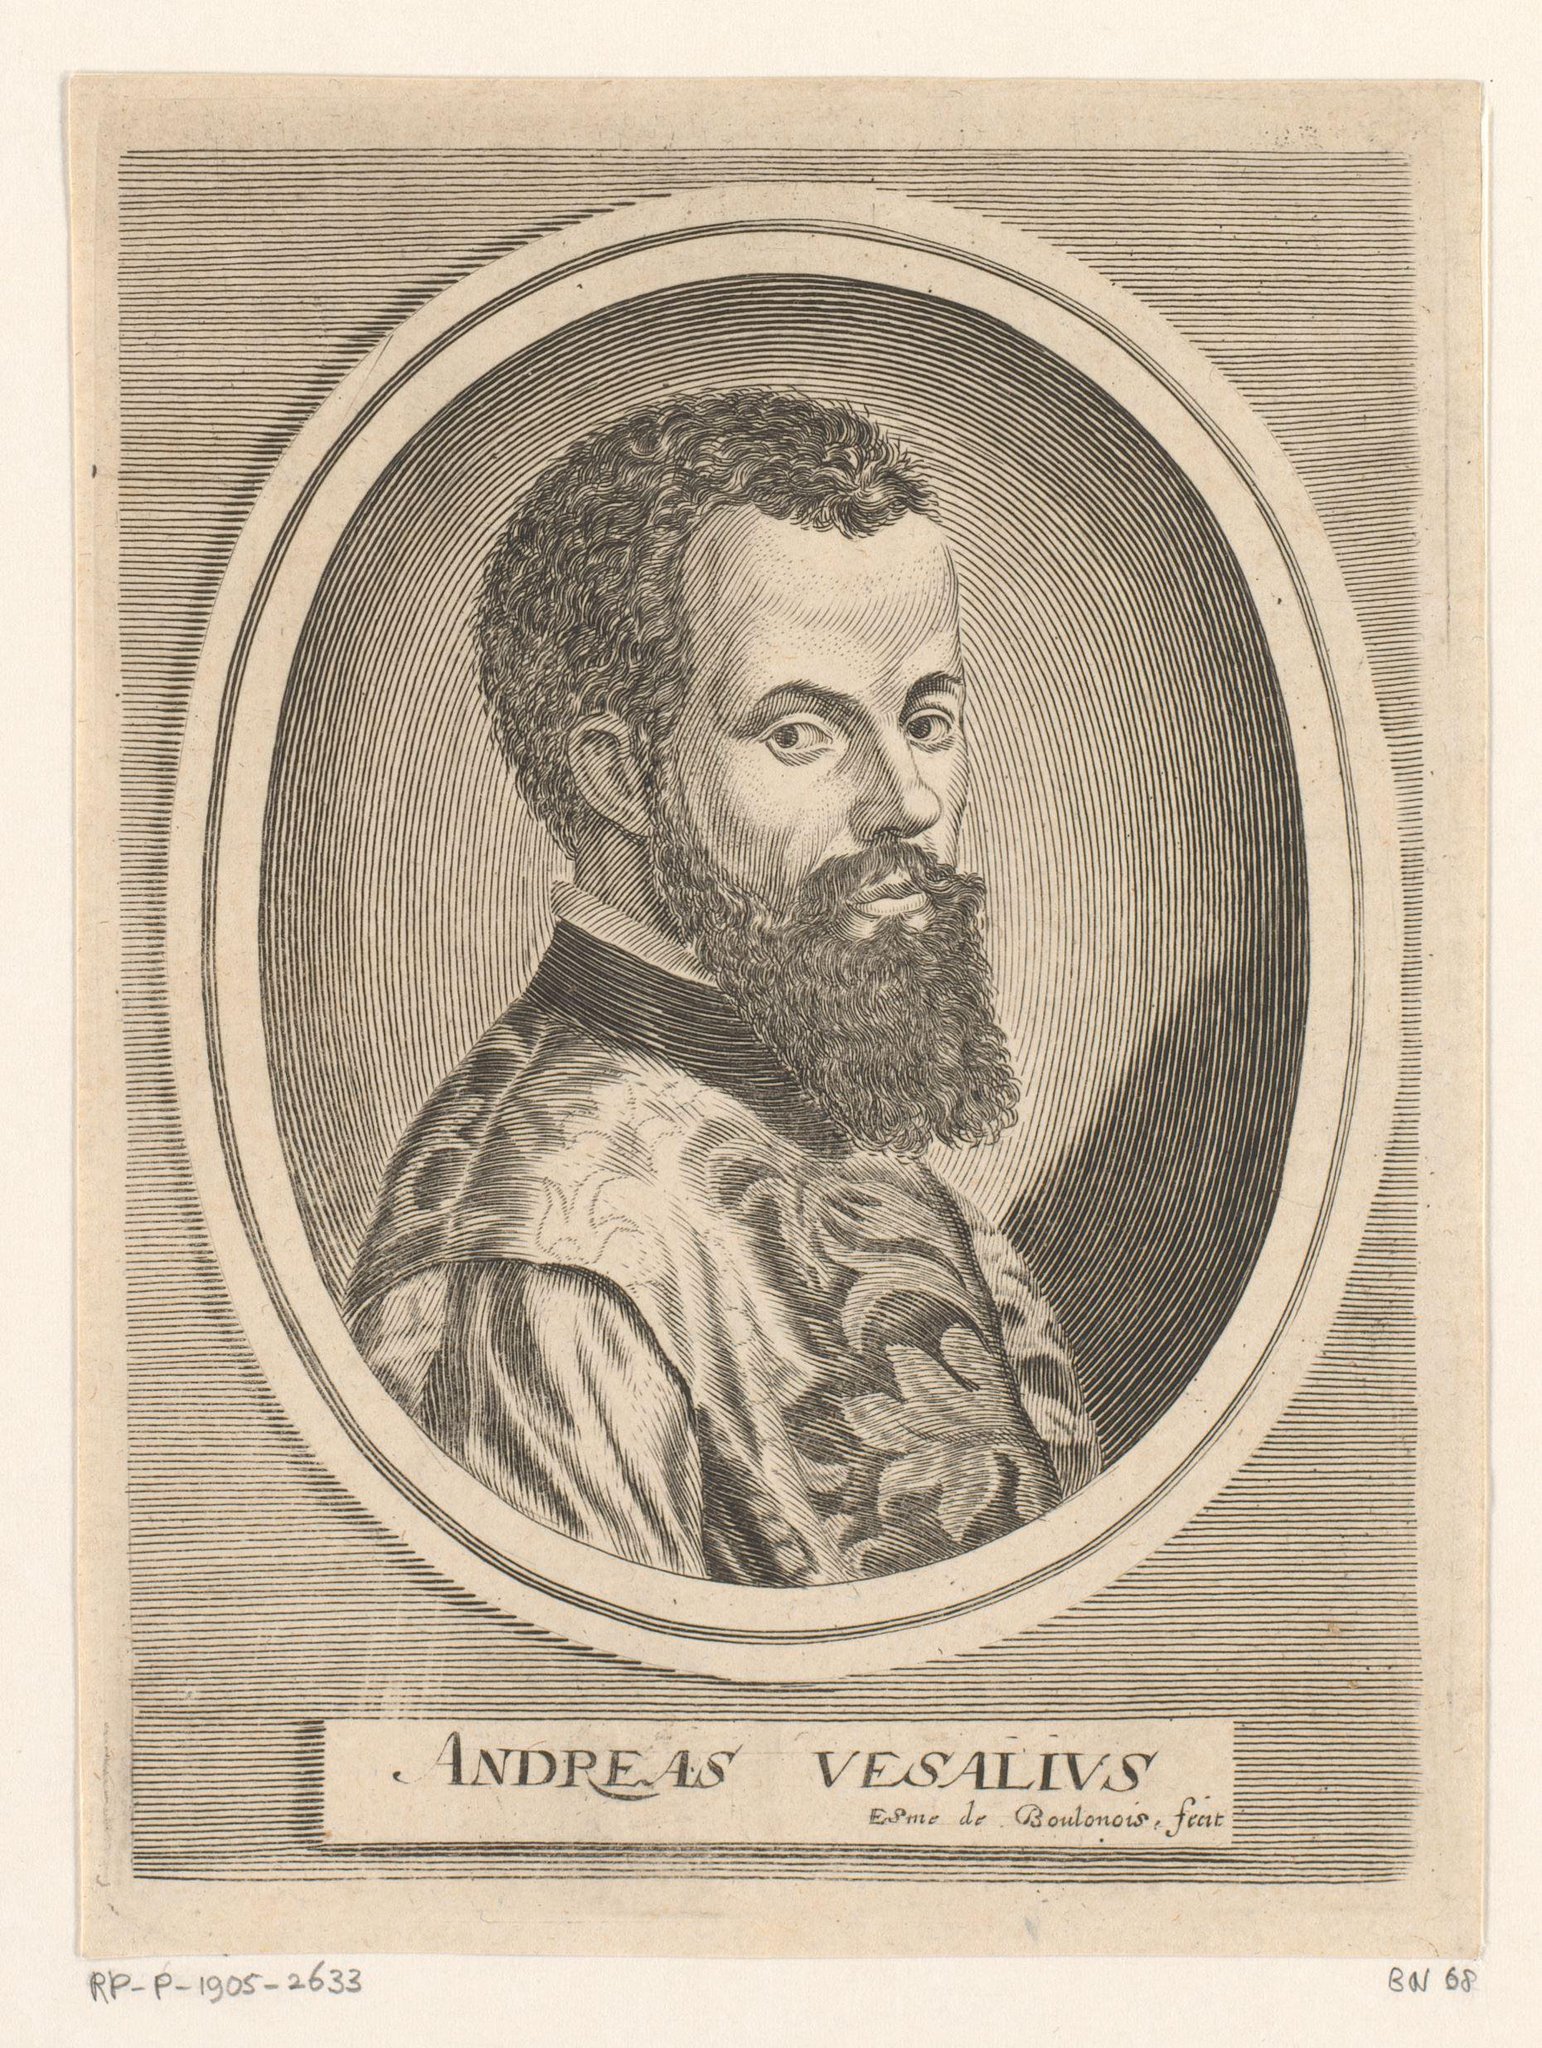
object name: book illustration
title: Andreas Vesalius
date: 1682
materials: paper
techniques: engraving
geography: brussels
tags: anatomy (non-medical), historical persons, physician, doctor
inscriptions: collector's mark: Lugt 2228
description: Prent uit: Bullert, Isaac. Académie des Sciences et Arts contenant les vies et éloges his. des hommes illustres qui ont excellé en ces professions depuis environ quatre siècles. Brussel: Foppens, François, 1682. Het boek werd in 1682 eveneens in Amsterdam uitgegeven door de erfgenamen van Daniel Elzevier. Deze portretten dienen ter illustratie van de biografie van een kunstenaar of geleerde. De meeste portretten werden door Nicolas de Larmessin vervaardigd (162), 93 door De Boulonois en een derde door ongeïdentificeerde prentmakers. Dit betreft een illustratie op p. 86, deel II.